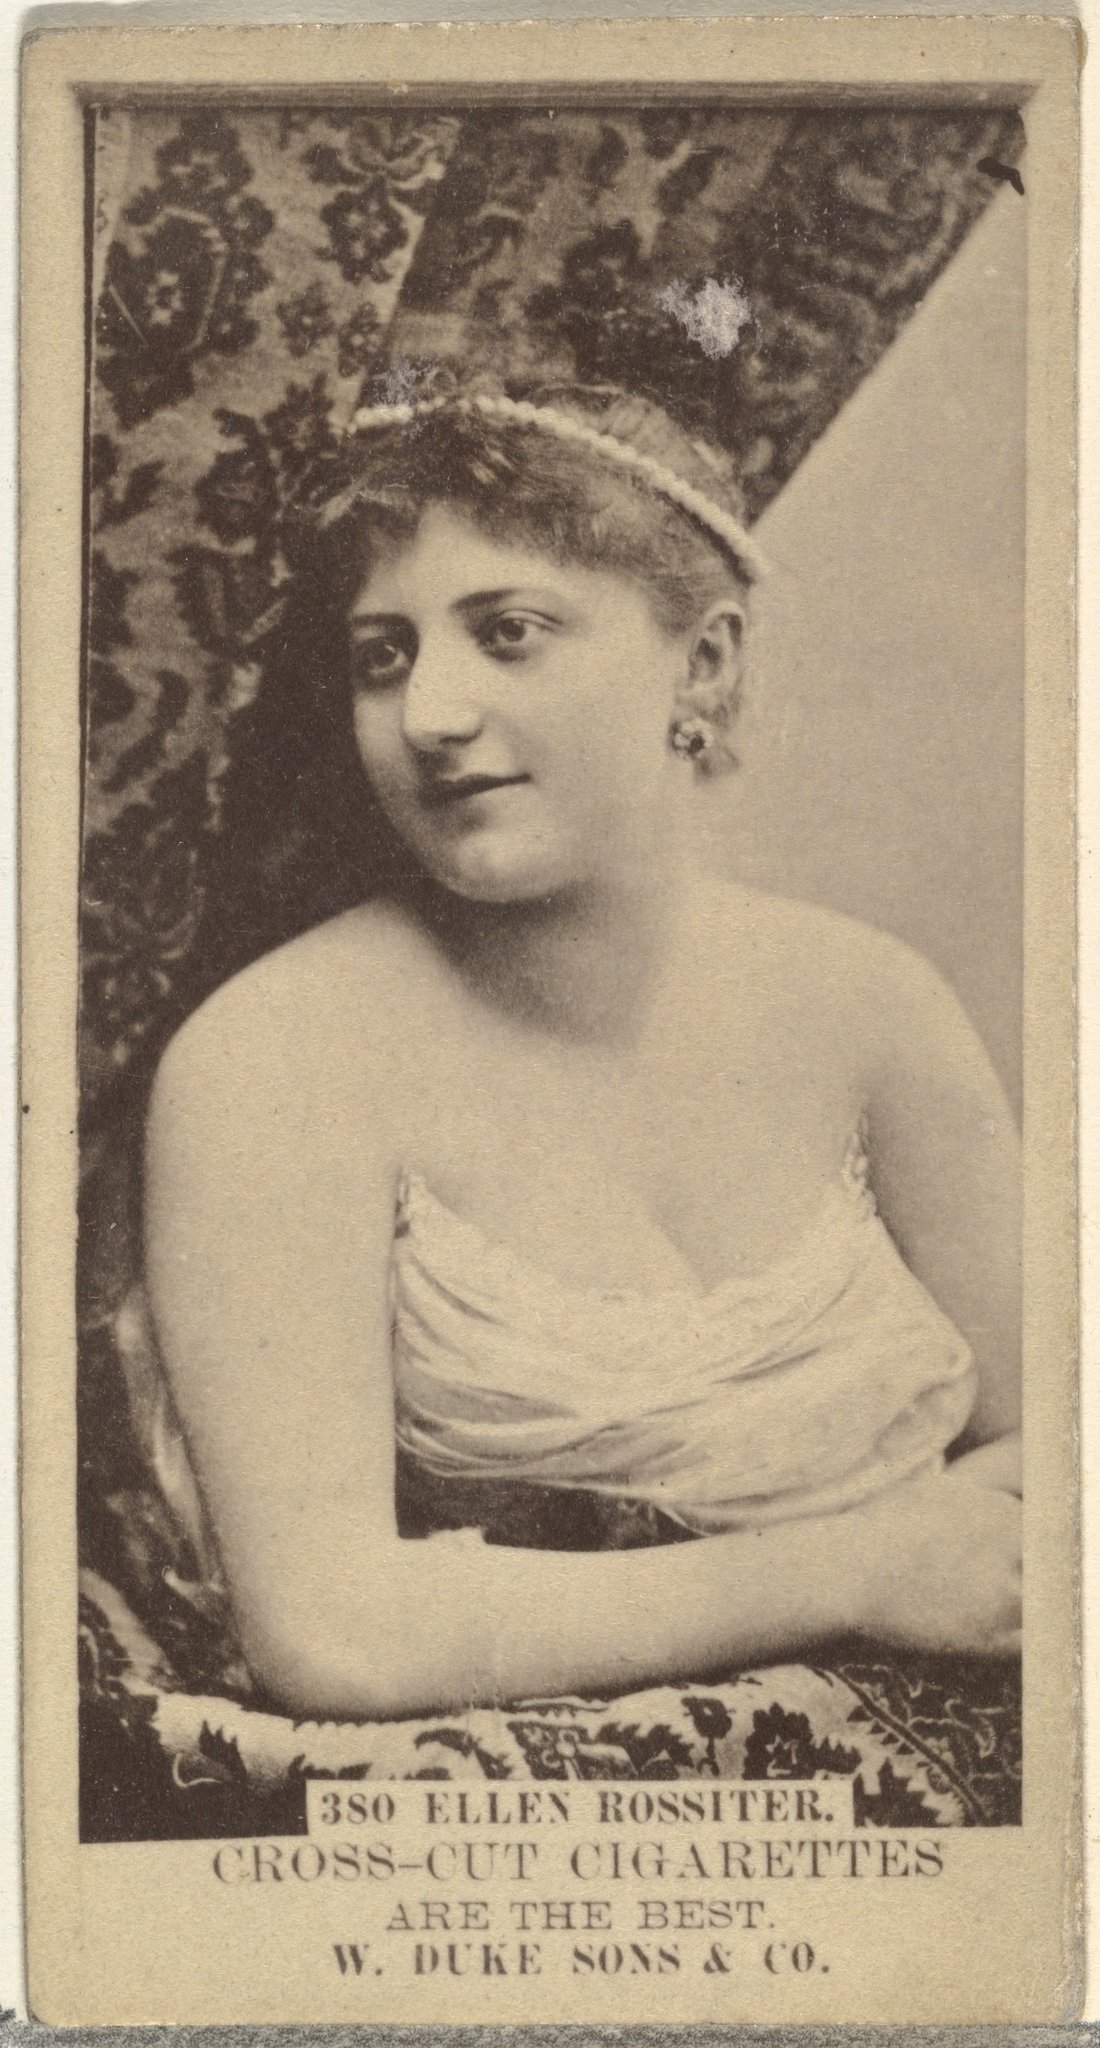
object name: photograph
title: Card Number 380, Ellen Rossiter, from the Actors and Actresses series (N145-3) issued by Duke Sons & Co. to promote Cross Cut Cigarettes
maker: w. duke, sons & co.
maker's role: publisher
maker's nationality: american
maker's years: 1870-1920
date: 1880-1889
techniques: albumen silver print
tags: portraits,women,actresses